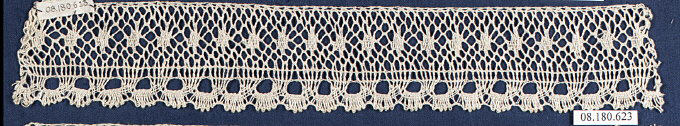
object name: piece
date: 1801-1900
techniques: lace